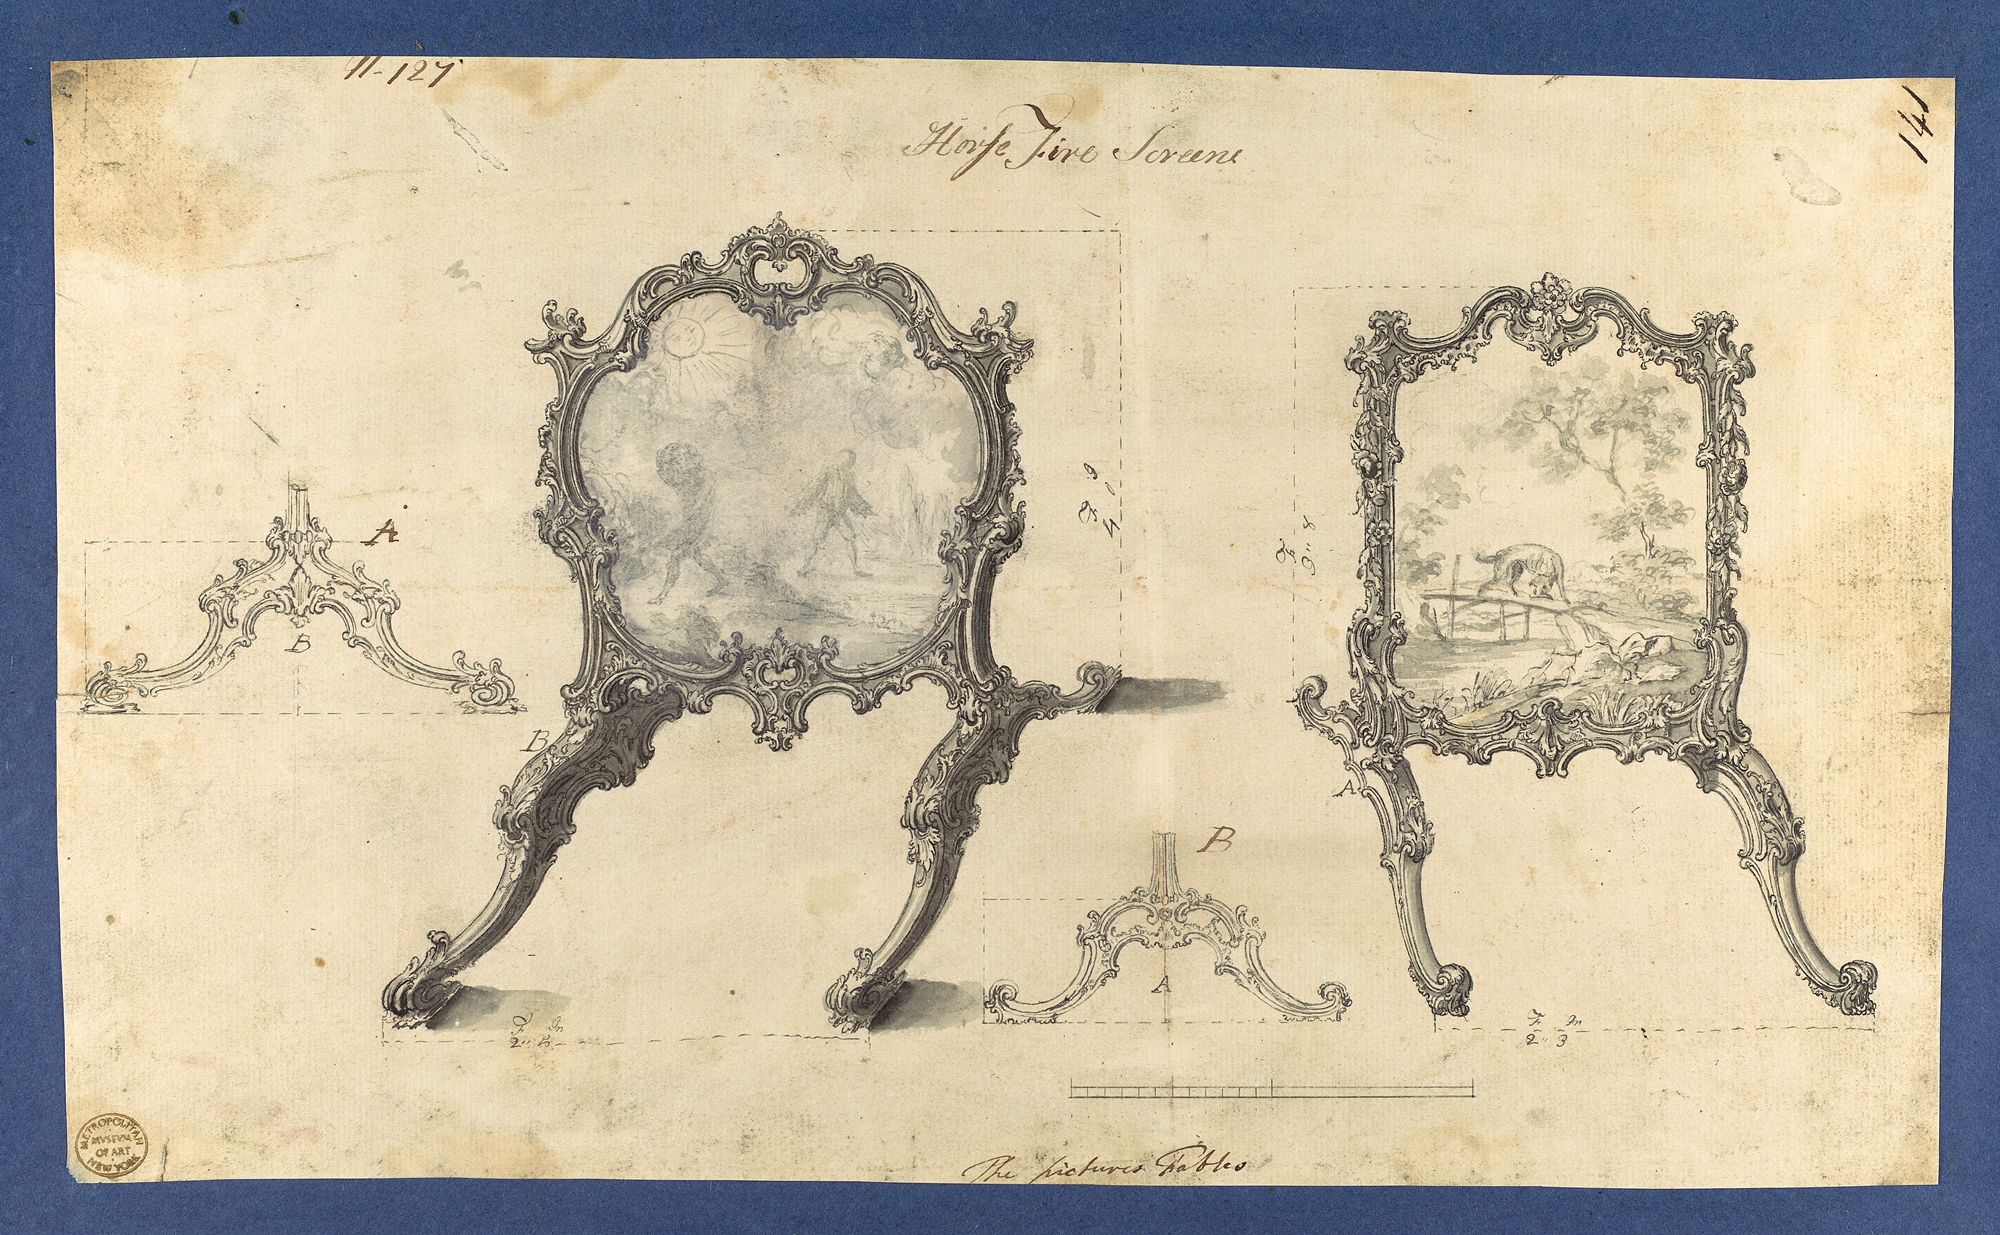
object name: drawing ornament architecture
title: Fire Screens, in Chippendale Drawings, Vol. I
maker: thomas chippendale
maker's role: artist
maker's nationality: british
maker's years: 1718-1779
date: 1754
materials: ink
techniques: wash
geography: london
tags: screens